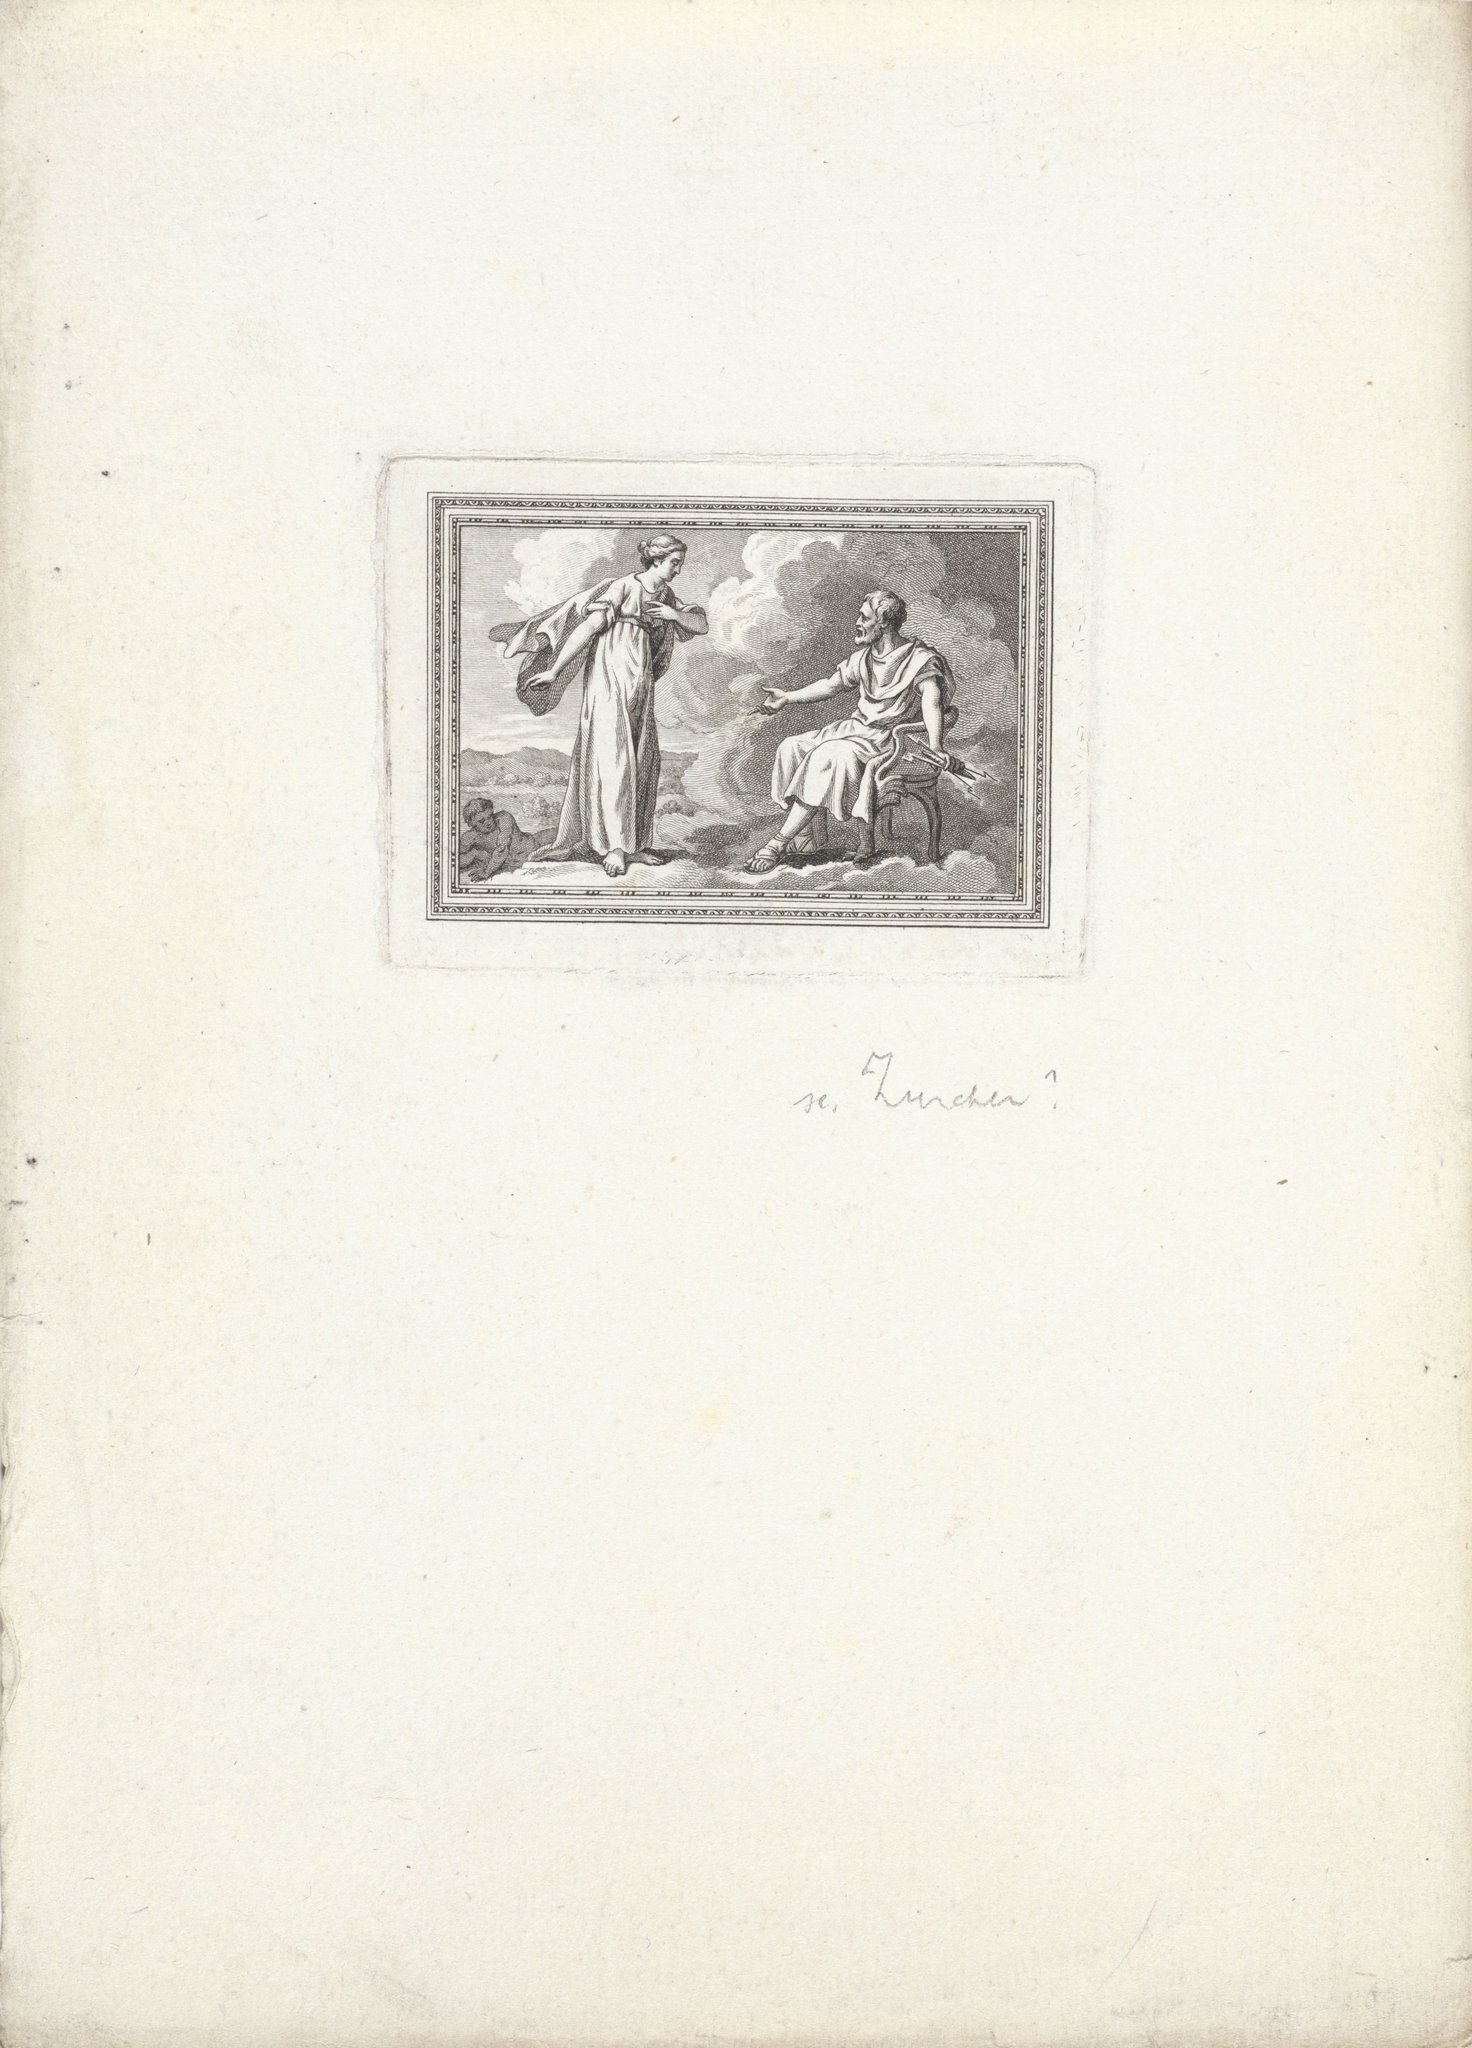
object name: book illustration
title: Vriendschap beklaagt zich bij Jupiter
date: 1792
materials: paper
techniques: etching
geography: amsterdam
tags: (story of) jupiter (zeus), friendship; 'amicitia' (ripa)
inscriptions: collector's mark: Lugt 2228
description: De vriendschap beklaagt zich bij Jupiter over de Vleierij die zich als haar voordoet. Illustratie bij het verhaal 'De vriendschap en de vleiery' uit 'Fabelen voor de Nederlandsche jeugd'.